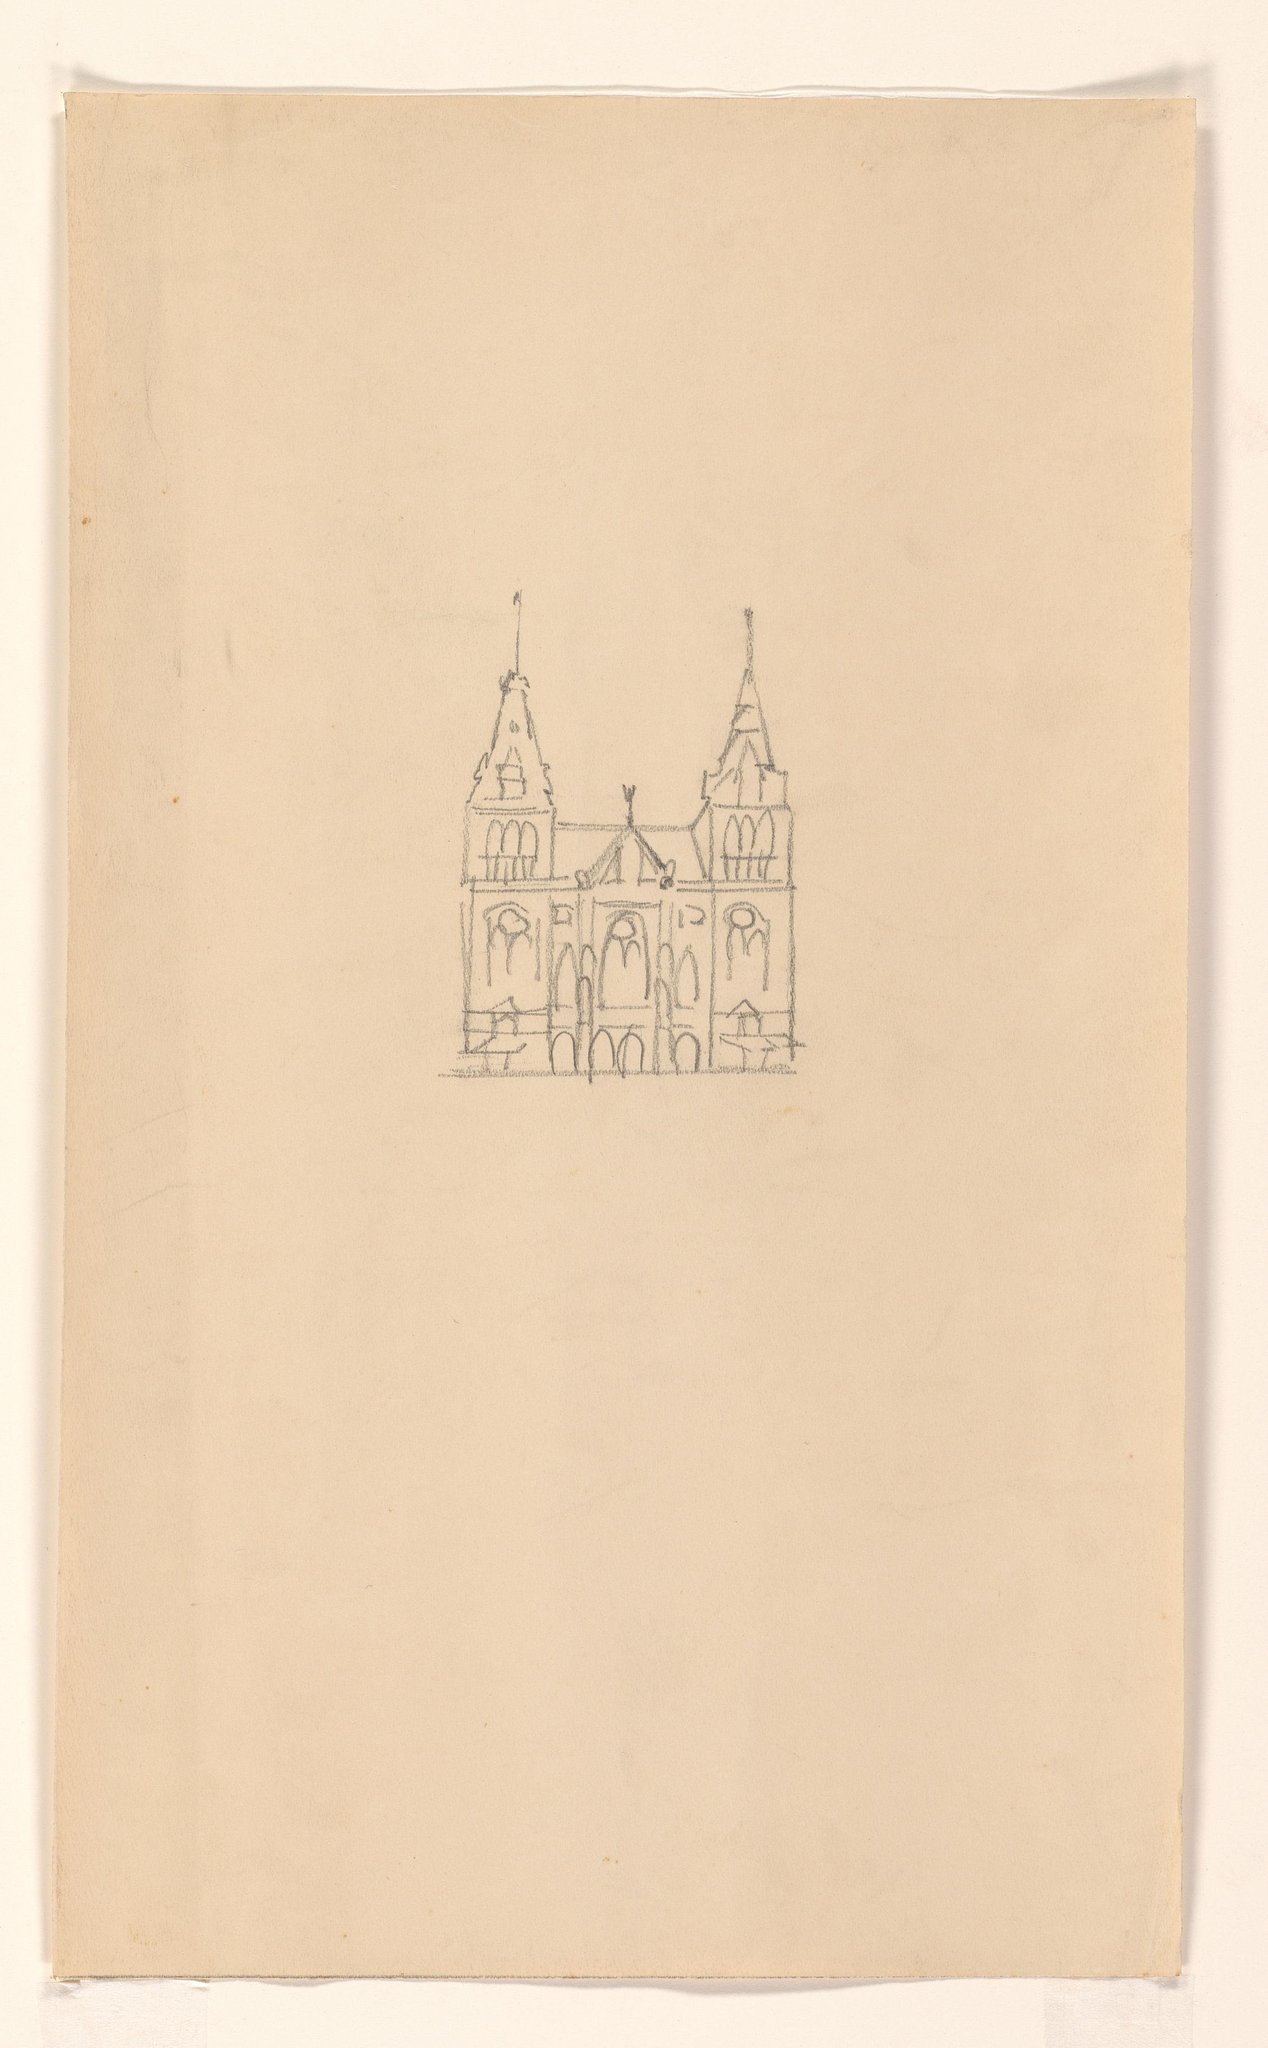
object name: drawing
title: Gezicht op het Rijksmuseum, zijde Stadhouderskade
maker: Anonymous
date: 1900-1999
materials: paper, pencil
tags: permanent exhibition, museum